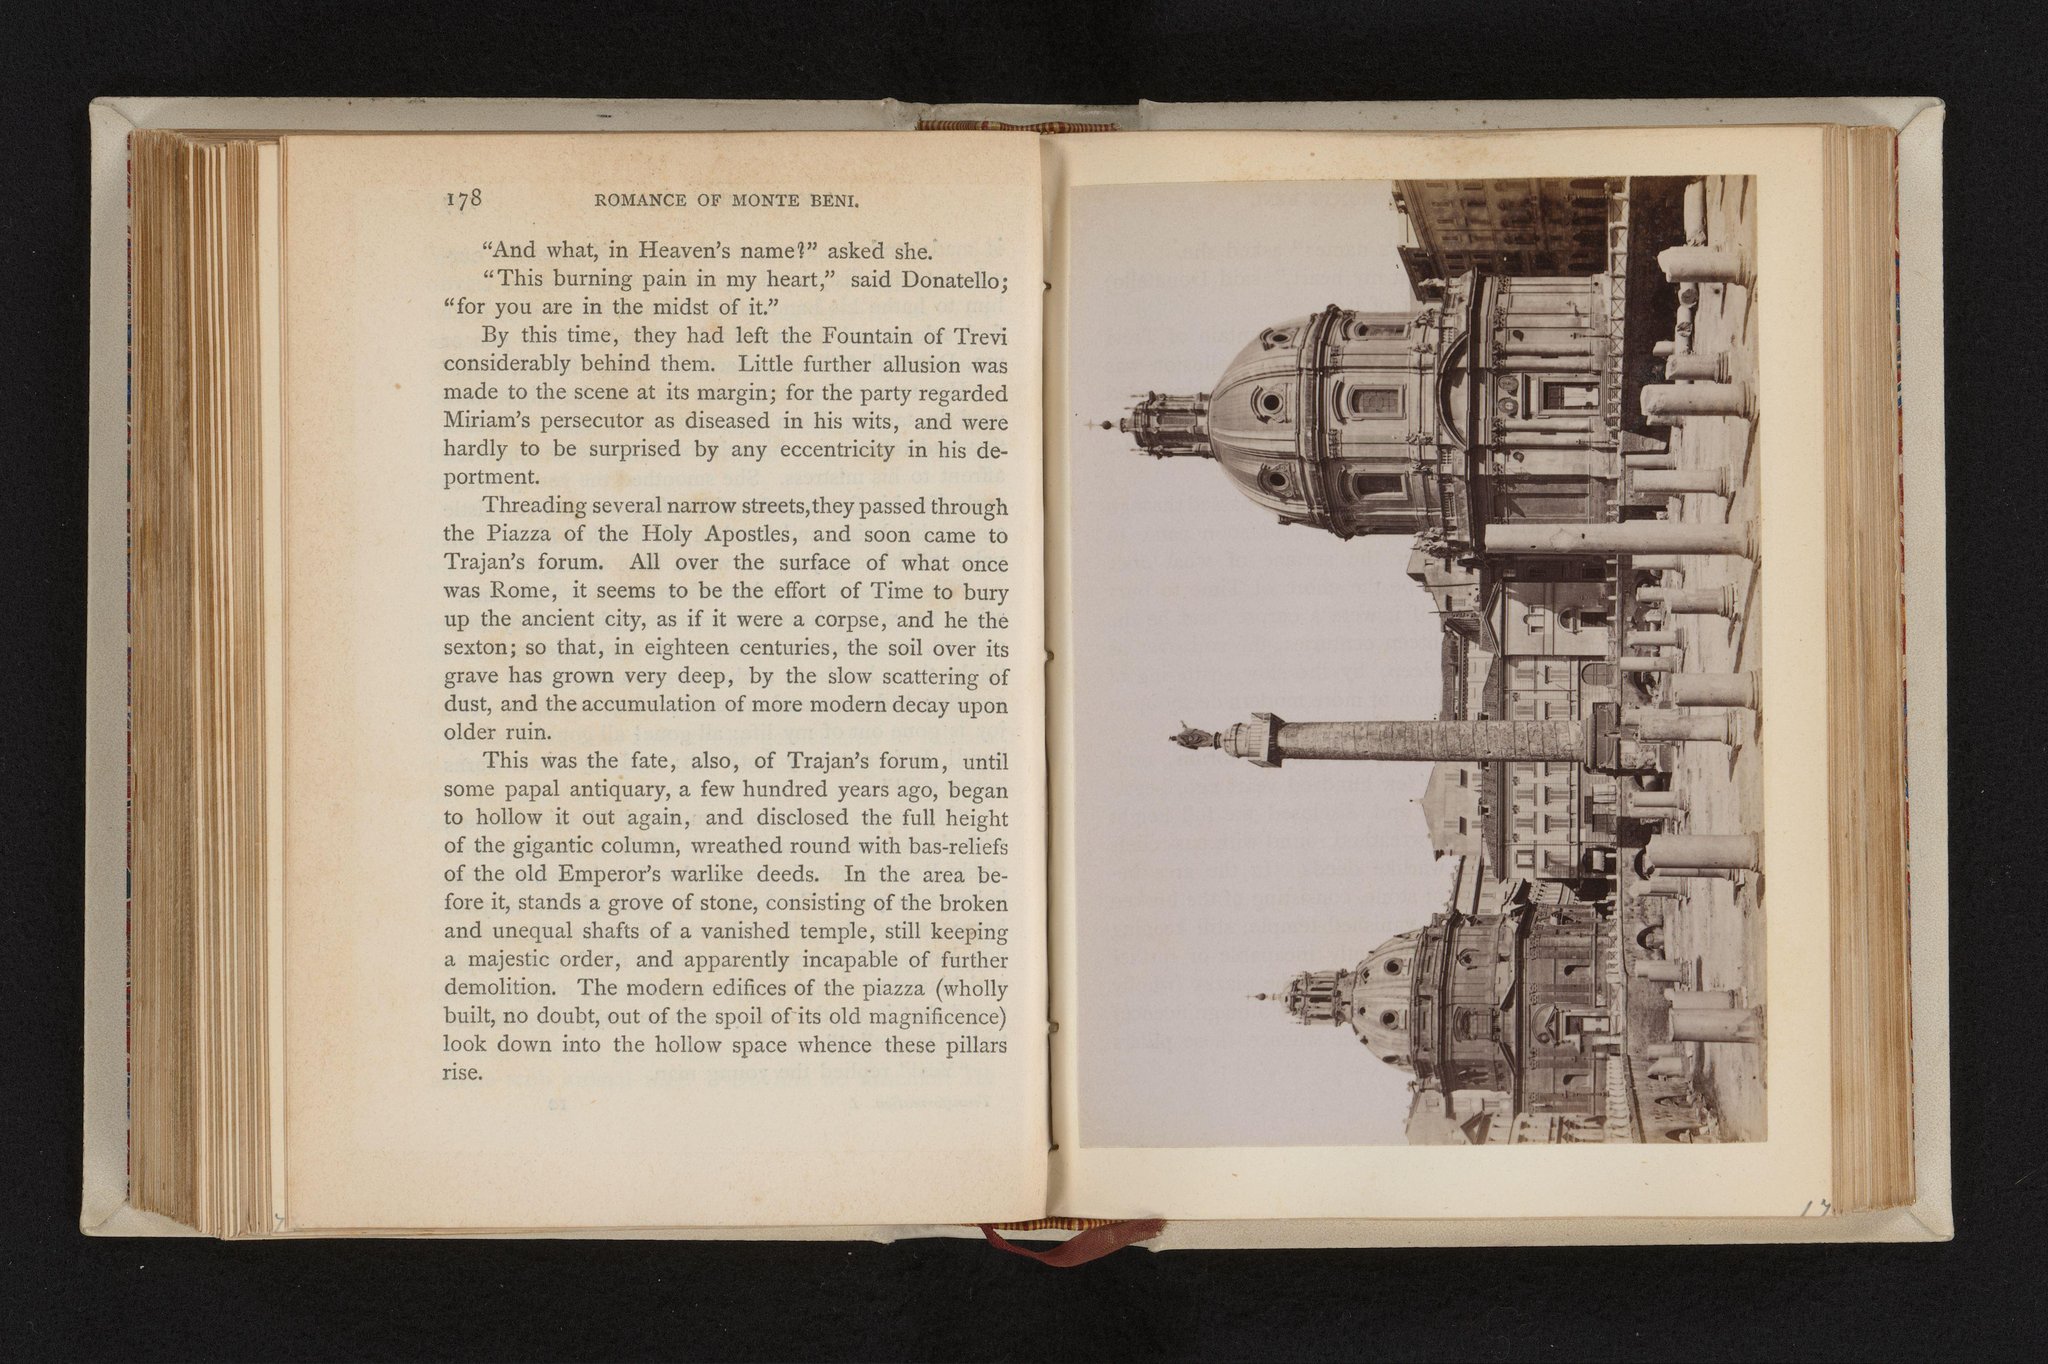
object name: photograph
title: Gezicht op het Forum van Trajanus met de zuil van Trajanus in Rome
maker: Anonymous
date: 1850-1860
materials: photographic support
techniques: albumen print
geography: rome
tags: monument, statue, dome ~ architecture